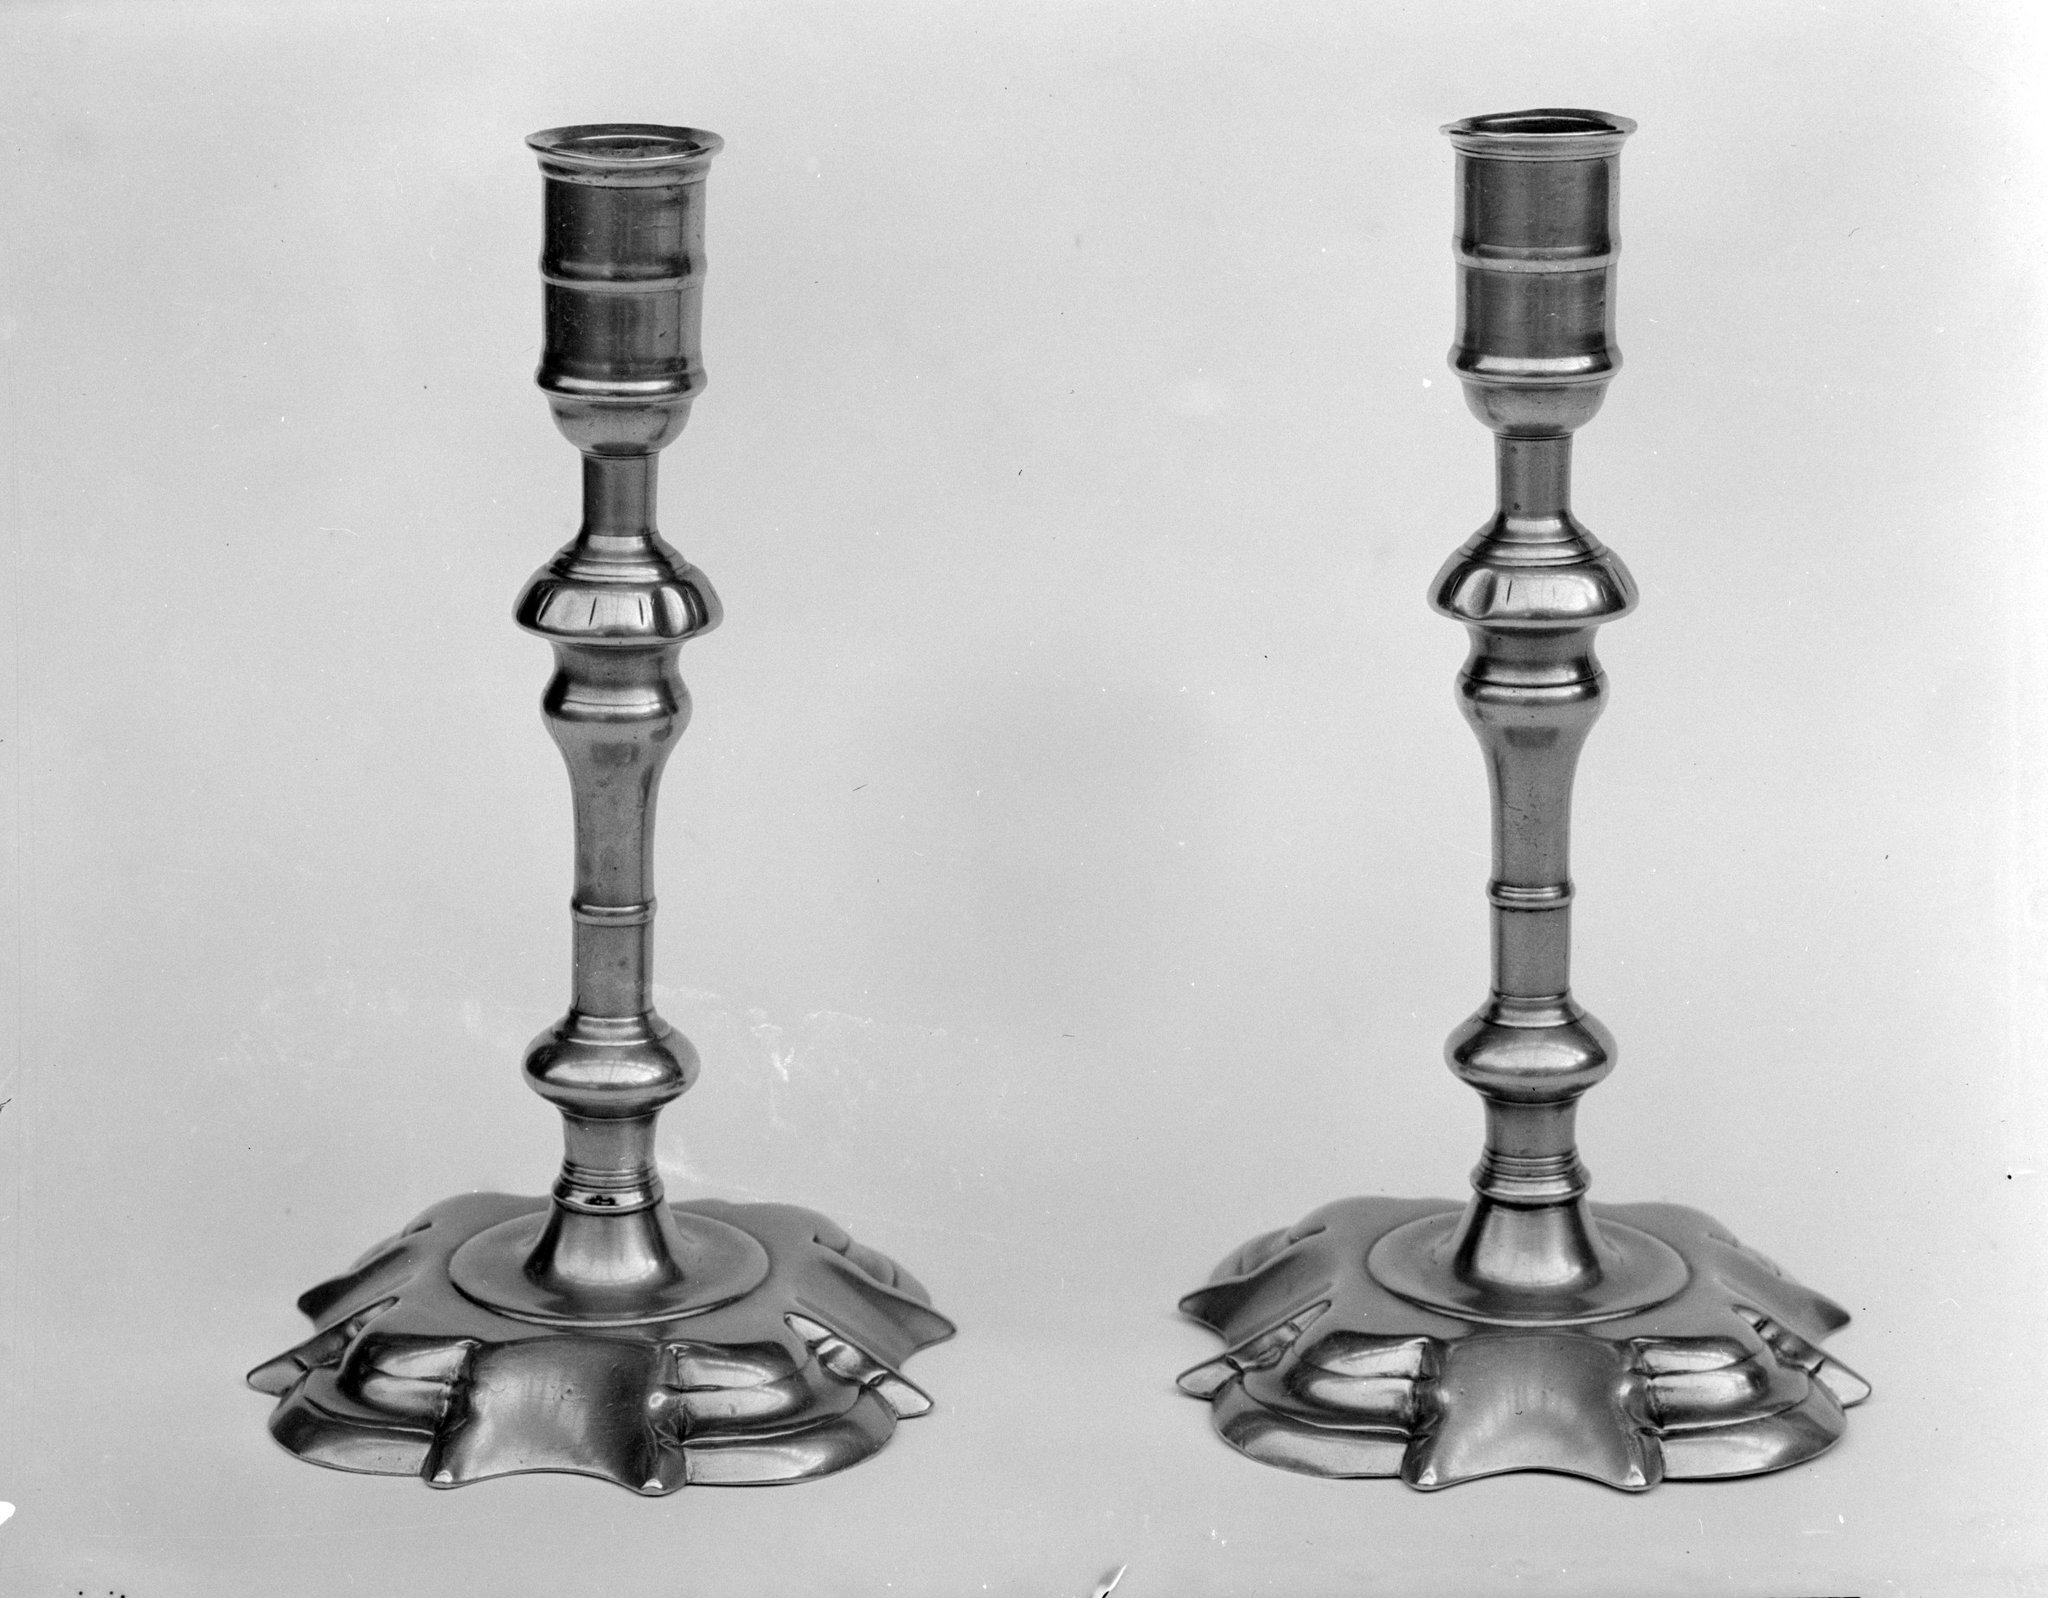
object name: candlestick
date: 1750-1770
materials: brass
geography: england